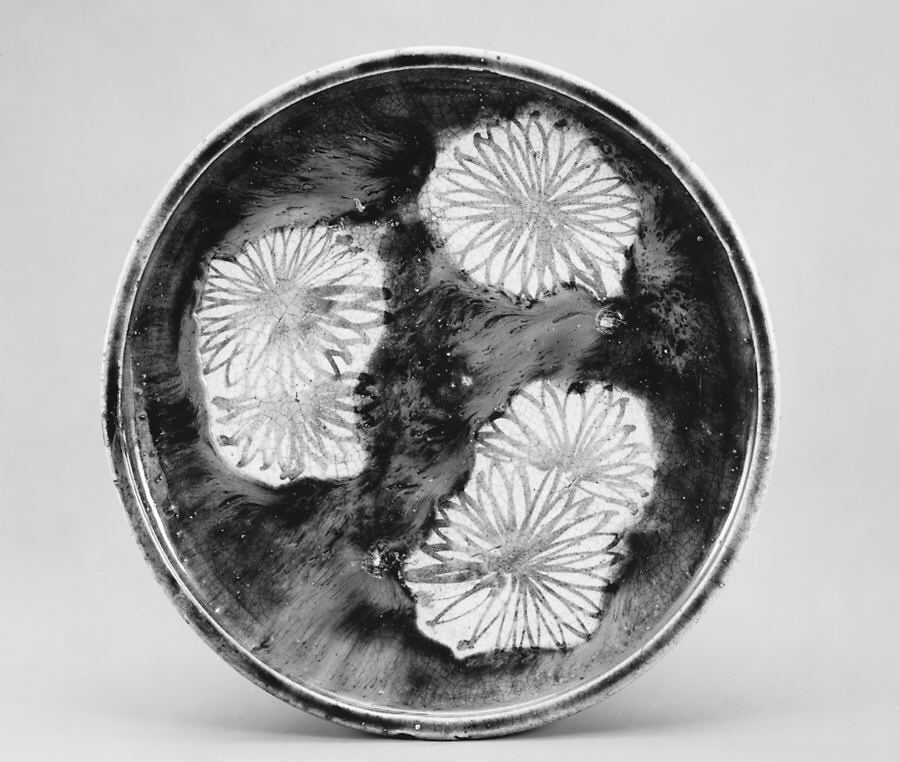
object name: plate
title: Plate with Chrysanthemum Design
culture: japanese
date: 1800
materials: iron, stoneware